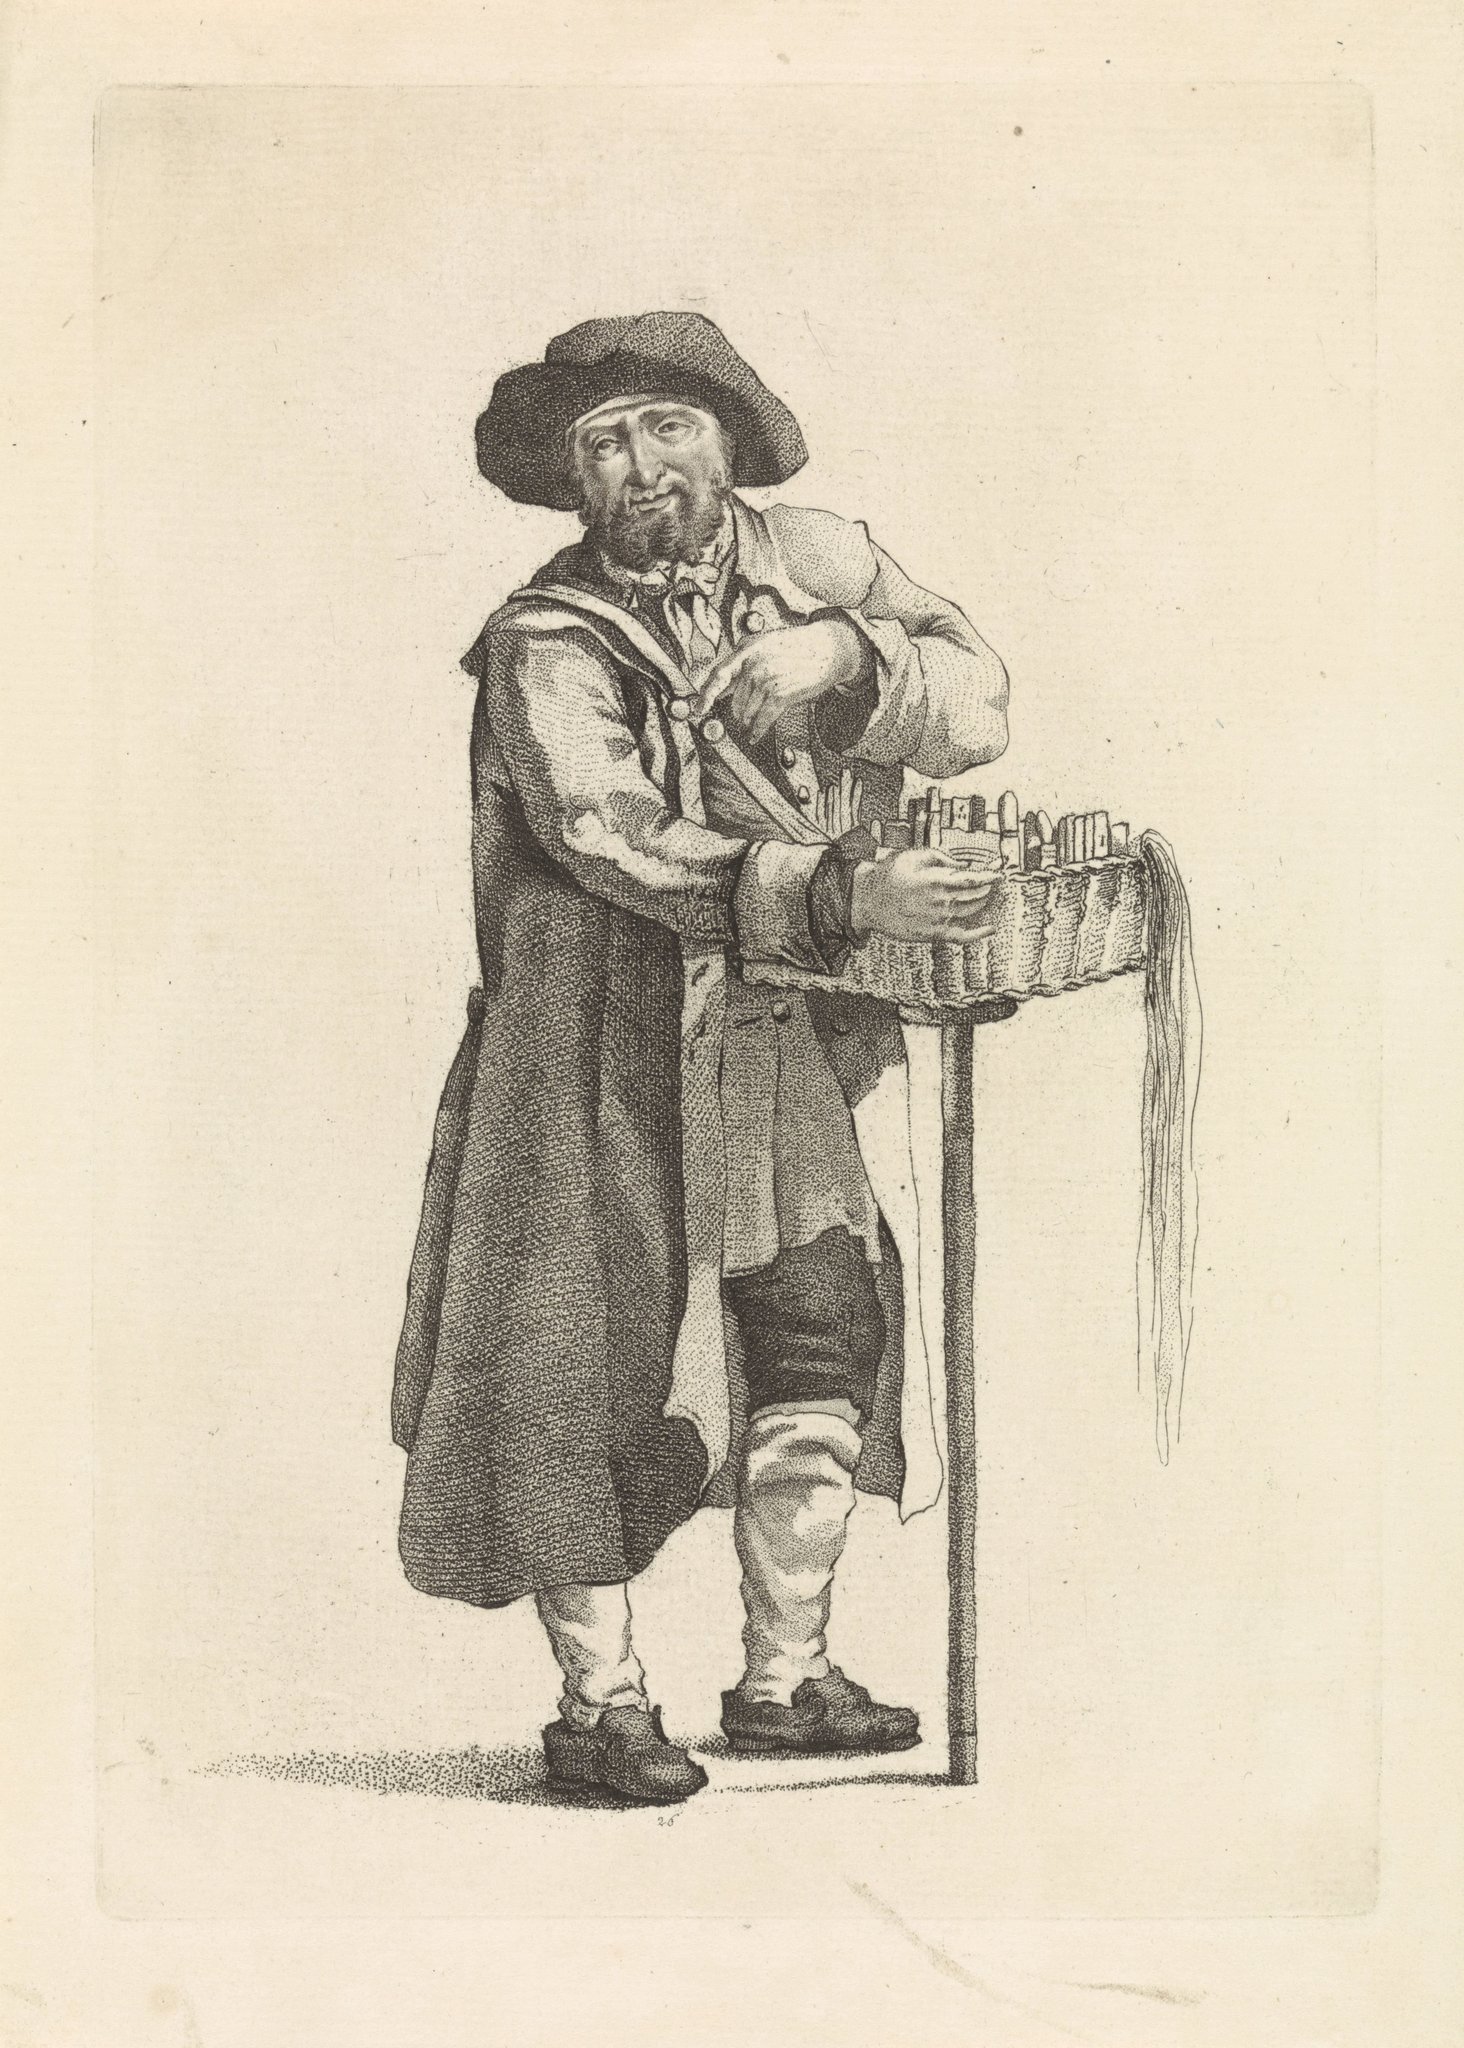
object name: print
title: Joodse straatventer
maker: mathias de sallieth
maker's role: print maker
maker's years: 1749-1791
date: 1772-1791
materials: paper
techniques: printmaking, etching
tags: container made of plant material other than wood: basket, the jews, jewish life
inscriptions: collector's mark: Lugt 2228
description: De prent verscheen vanaf 1818 tevens als onderdeel van een 33-delige reeks prenten door Mathias de Sallieth, samengebonden in: Perkois, Jacobus, Prins, Johannes Huibert. Verzameling van verschillende gekleede mans- en vrouwenstanden, ter oefening van jonge schilders en liefhebbers. Rotterdam: Johannes Immerzeel, 1818.